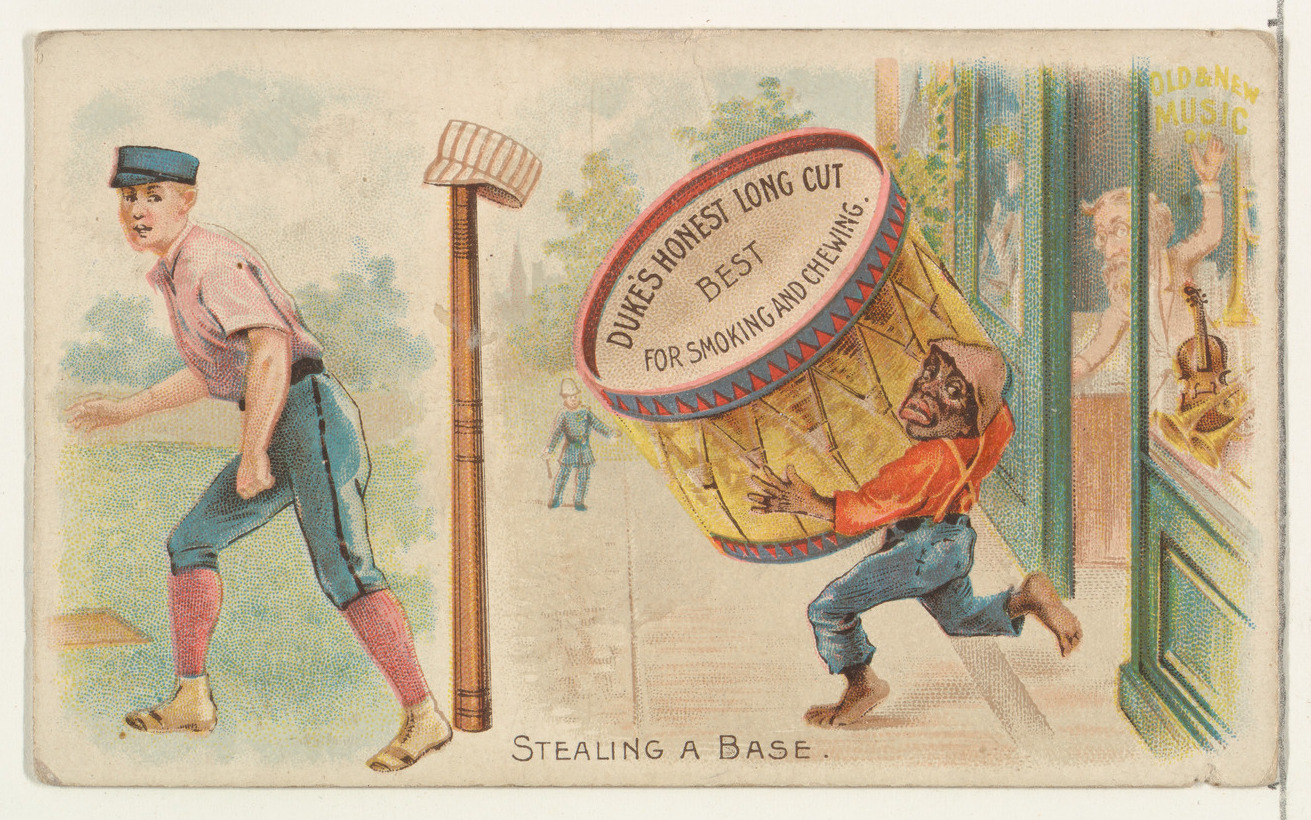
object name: print, baseball card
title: Stealing a Base, from the Talk of the Diamond set (N135) issued by Duke Sons & Co., a branch of the American Tobacco Company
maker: w. duke, sons & co.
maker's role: publisher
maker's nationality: american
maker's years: 1870-1920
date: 1888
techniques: color lithograph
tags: musical instruments,boys,men